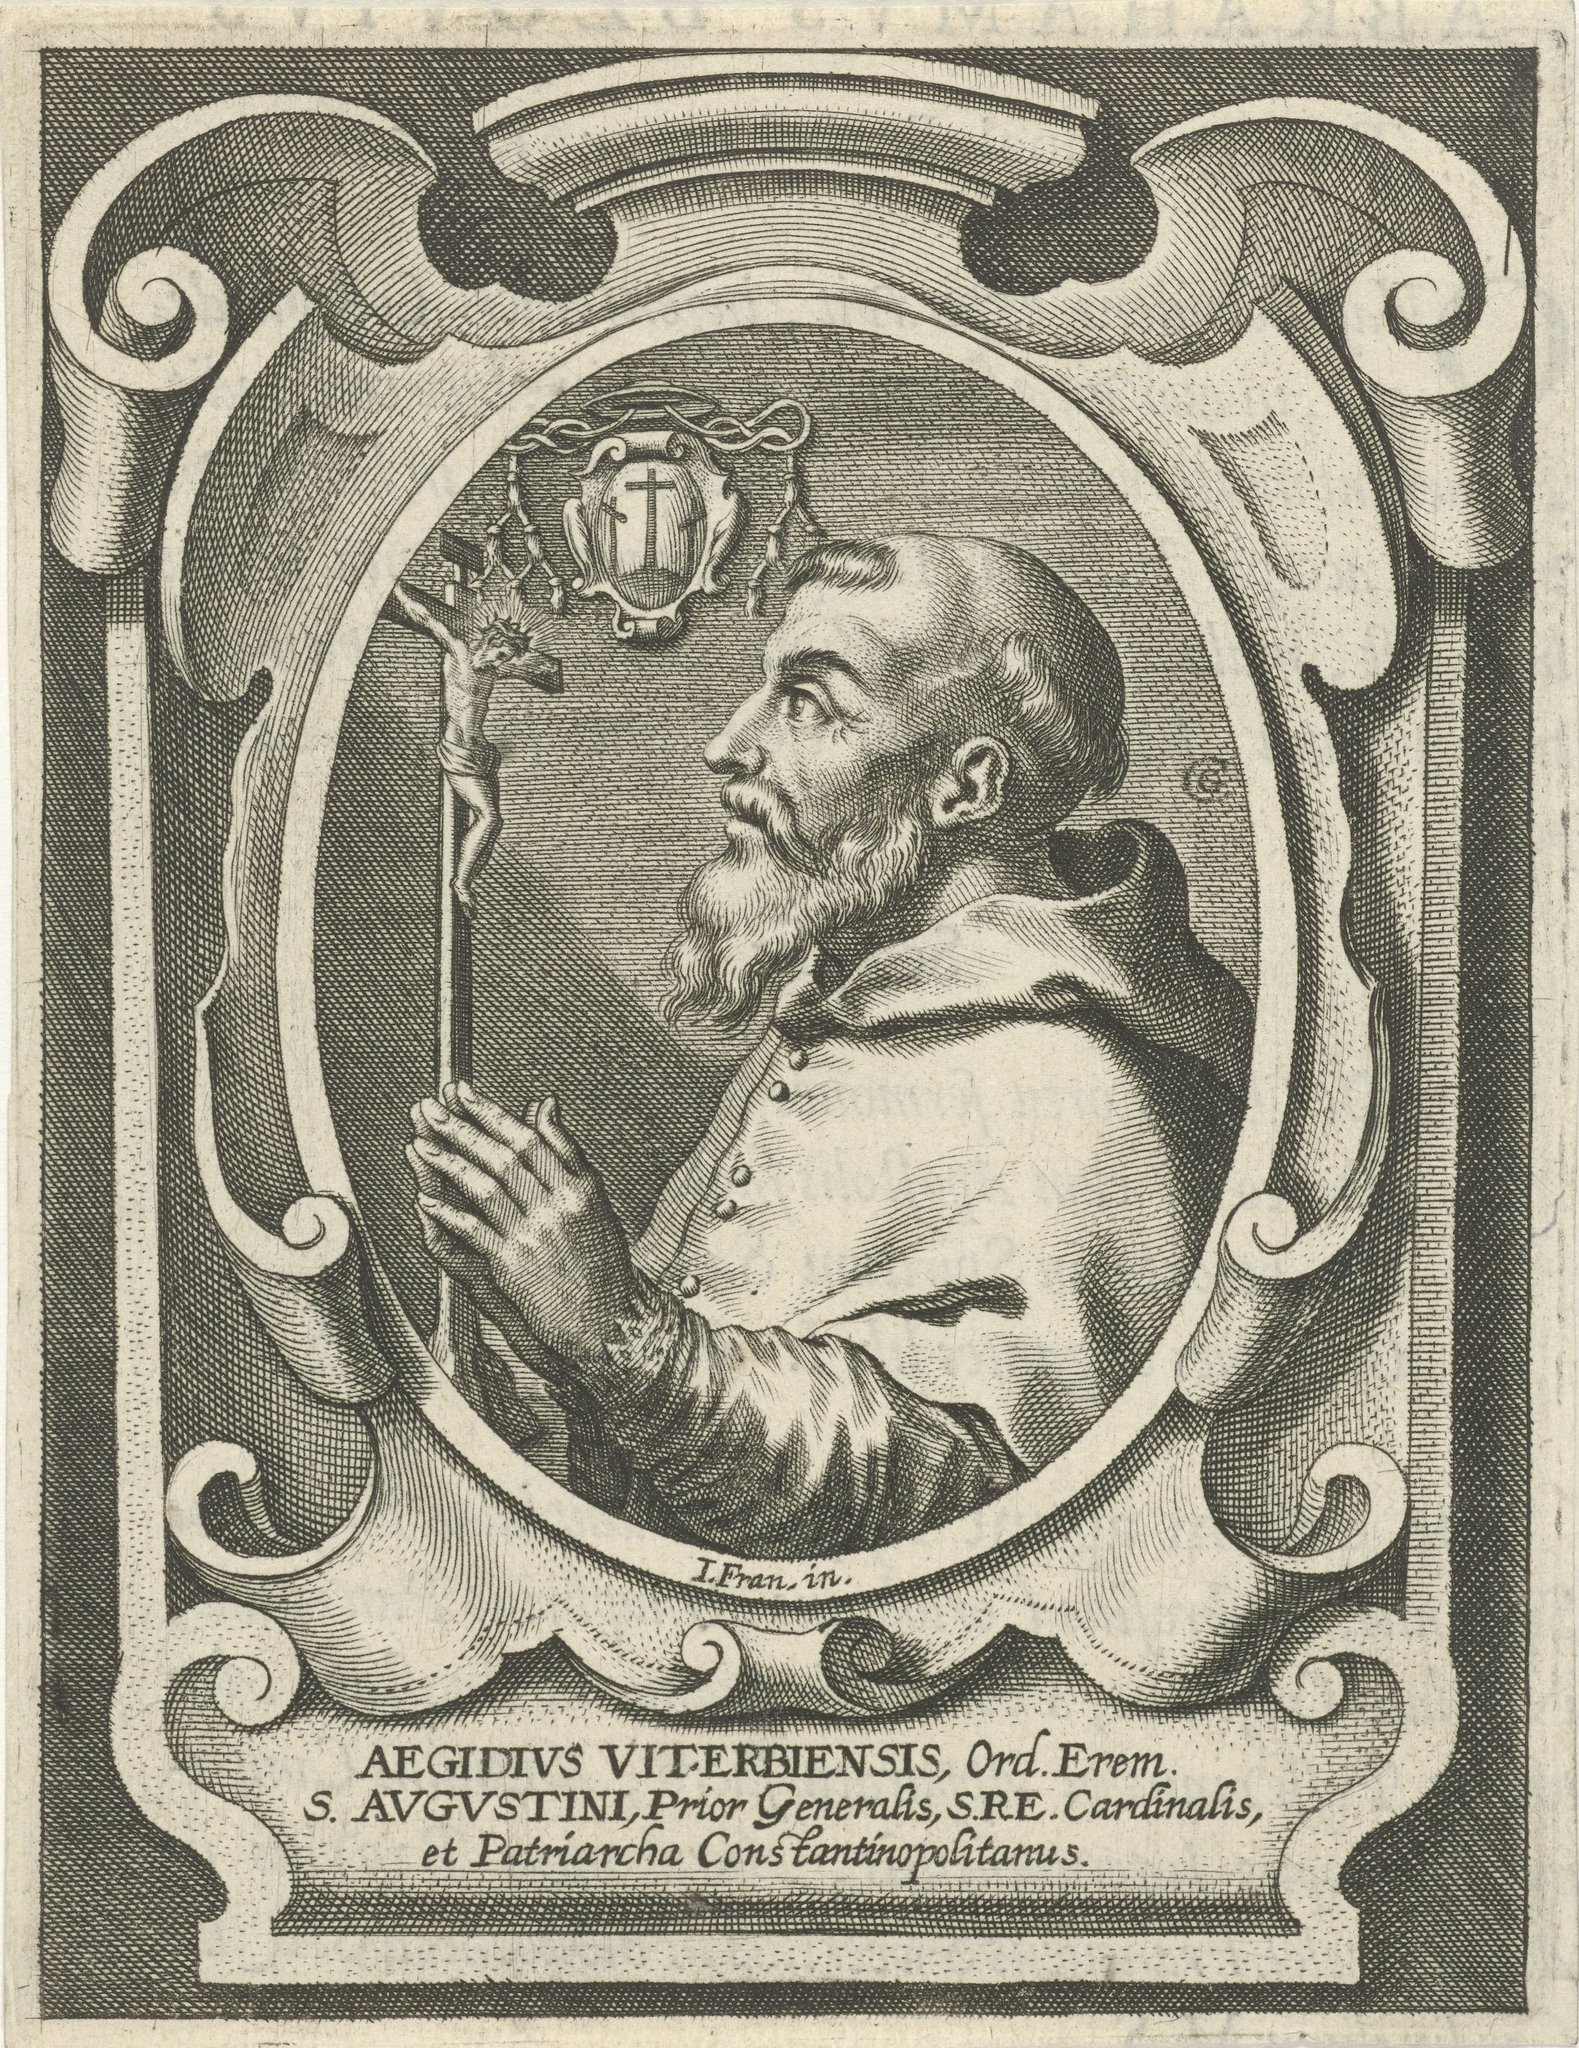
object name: print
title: Portret van de Augustijn en kardinaal Aegidius van Viterbo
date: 1636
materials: paper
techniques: engraving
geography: southern netherlands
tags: monastic orders, monastic life ~ roman catholic church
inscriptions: collector's mark: Lugt 2228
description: Boekillustratie voor: C. Curtius, Virorum illustrium ex ordine Eremitarum D. Augustini elogia , Antwerpen: J. Cnobbaert, 1636.